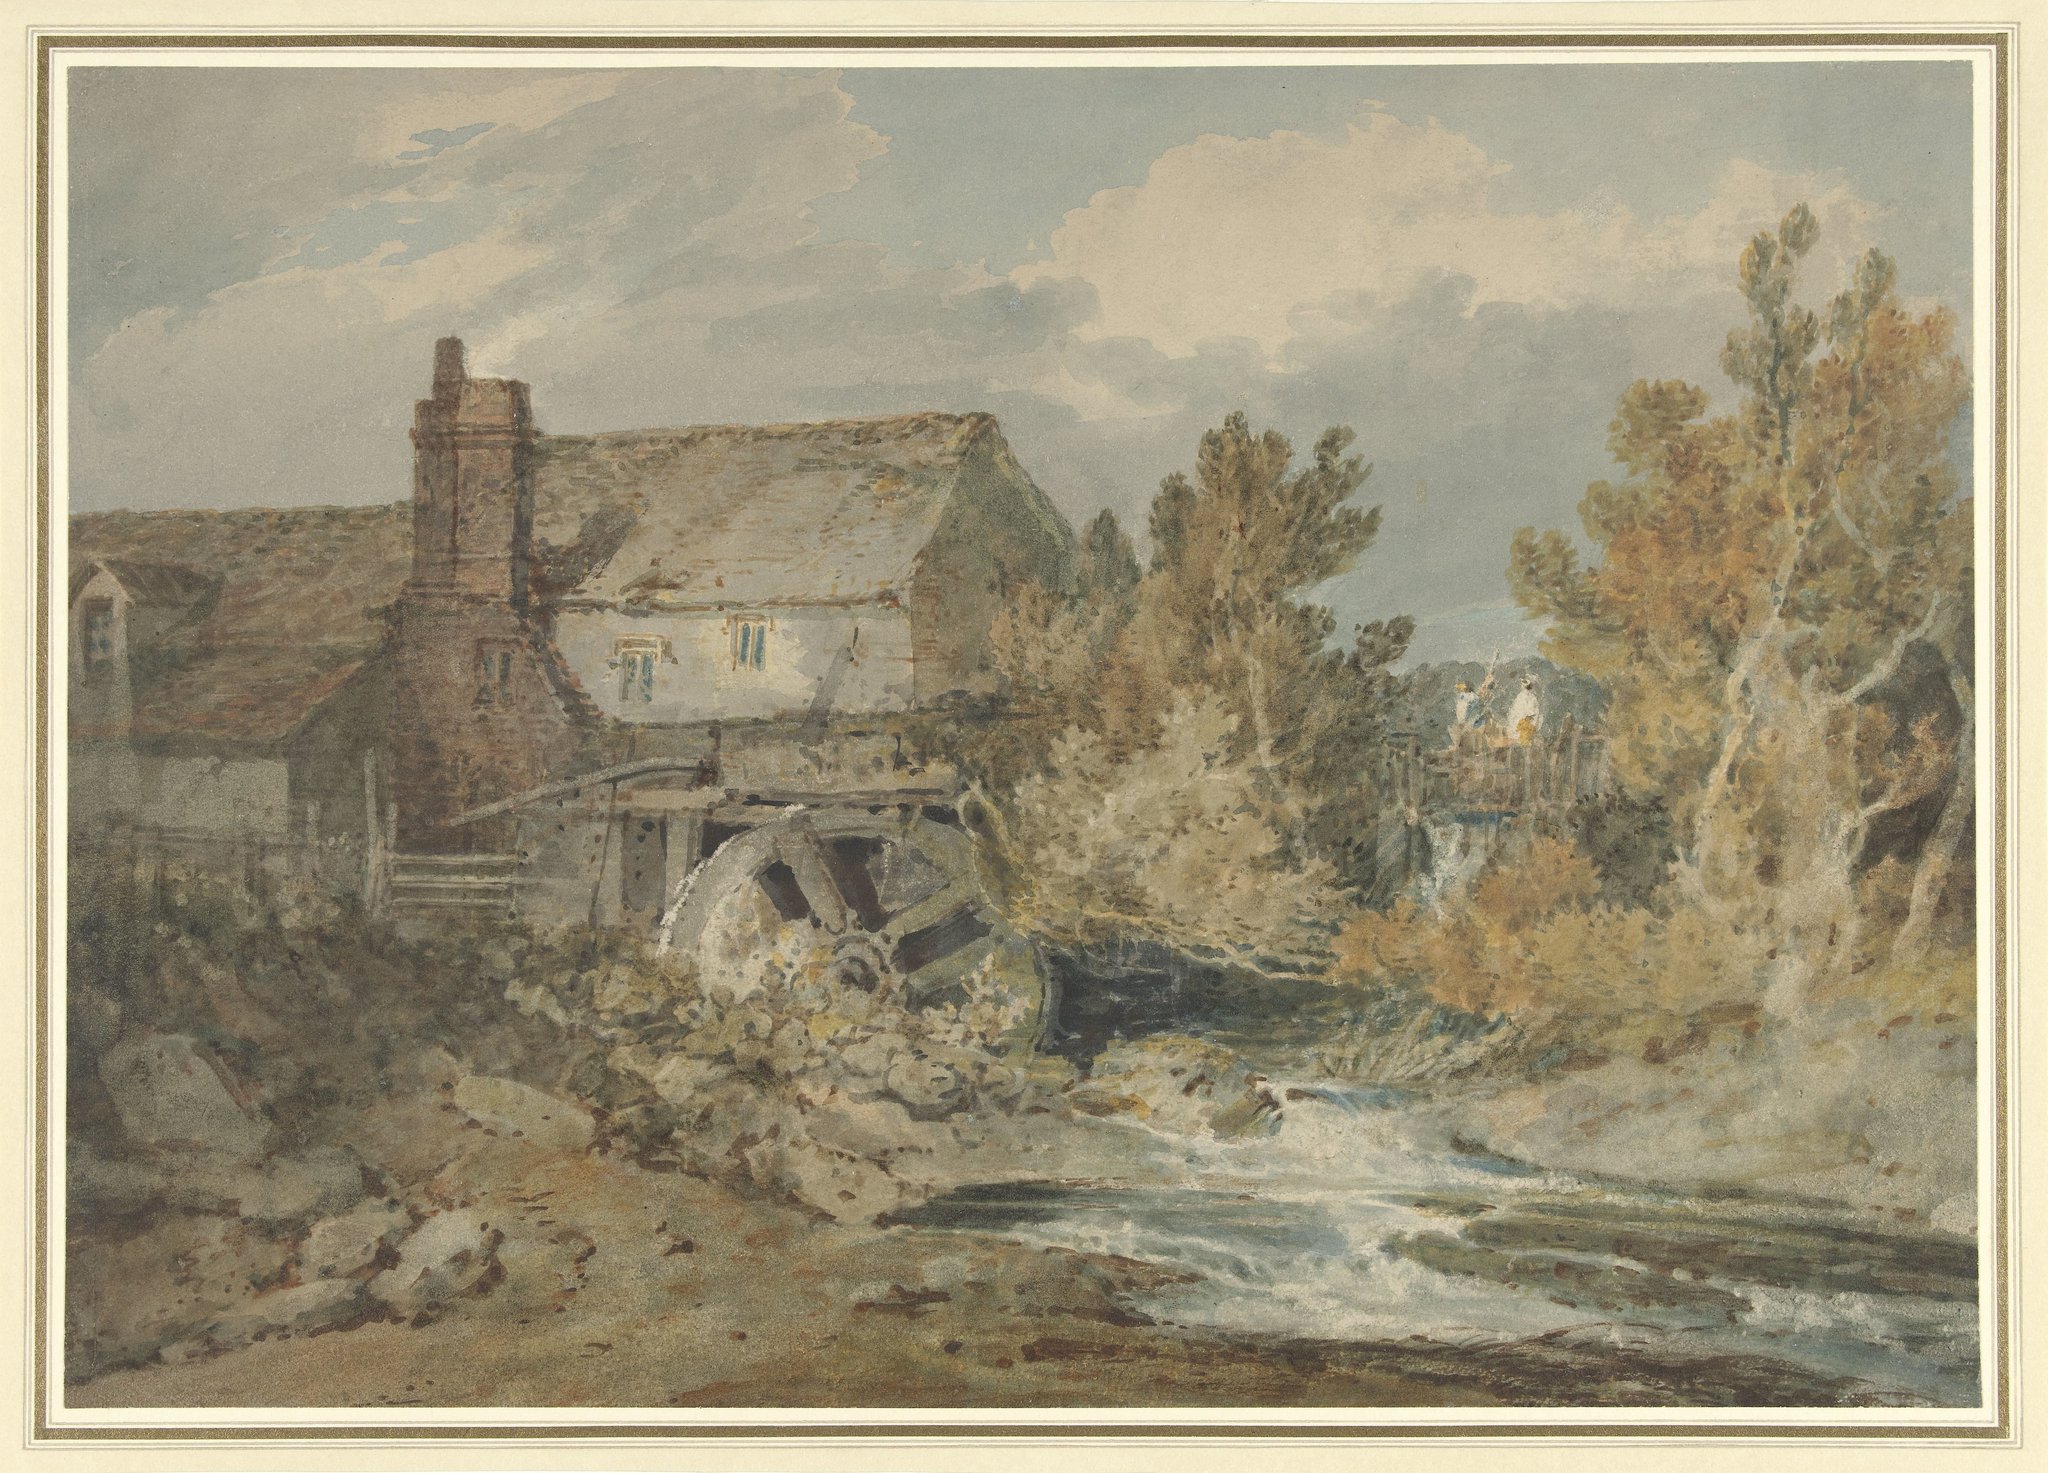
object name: drawing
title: Watermill near a Flowing Brook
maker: joseph mallord william turner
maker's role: draughtsman, print maker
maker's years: 1775-1851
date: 1795-1797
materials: paper, watercolor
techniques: brush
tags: watermill in landscape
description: With his grand visionary landscapes, William Turner would become one of the most important artists of the 19th century. The seed of this development is already contained in this early watercolour. By eliminating clear contours, Turner created a great sense of unity in the scene. He scraped off areas of pigment in places, as a result of which the water of the brook seems to be in constant motion.